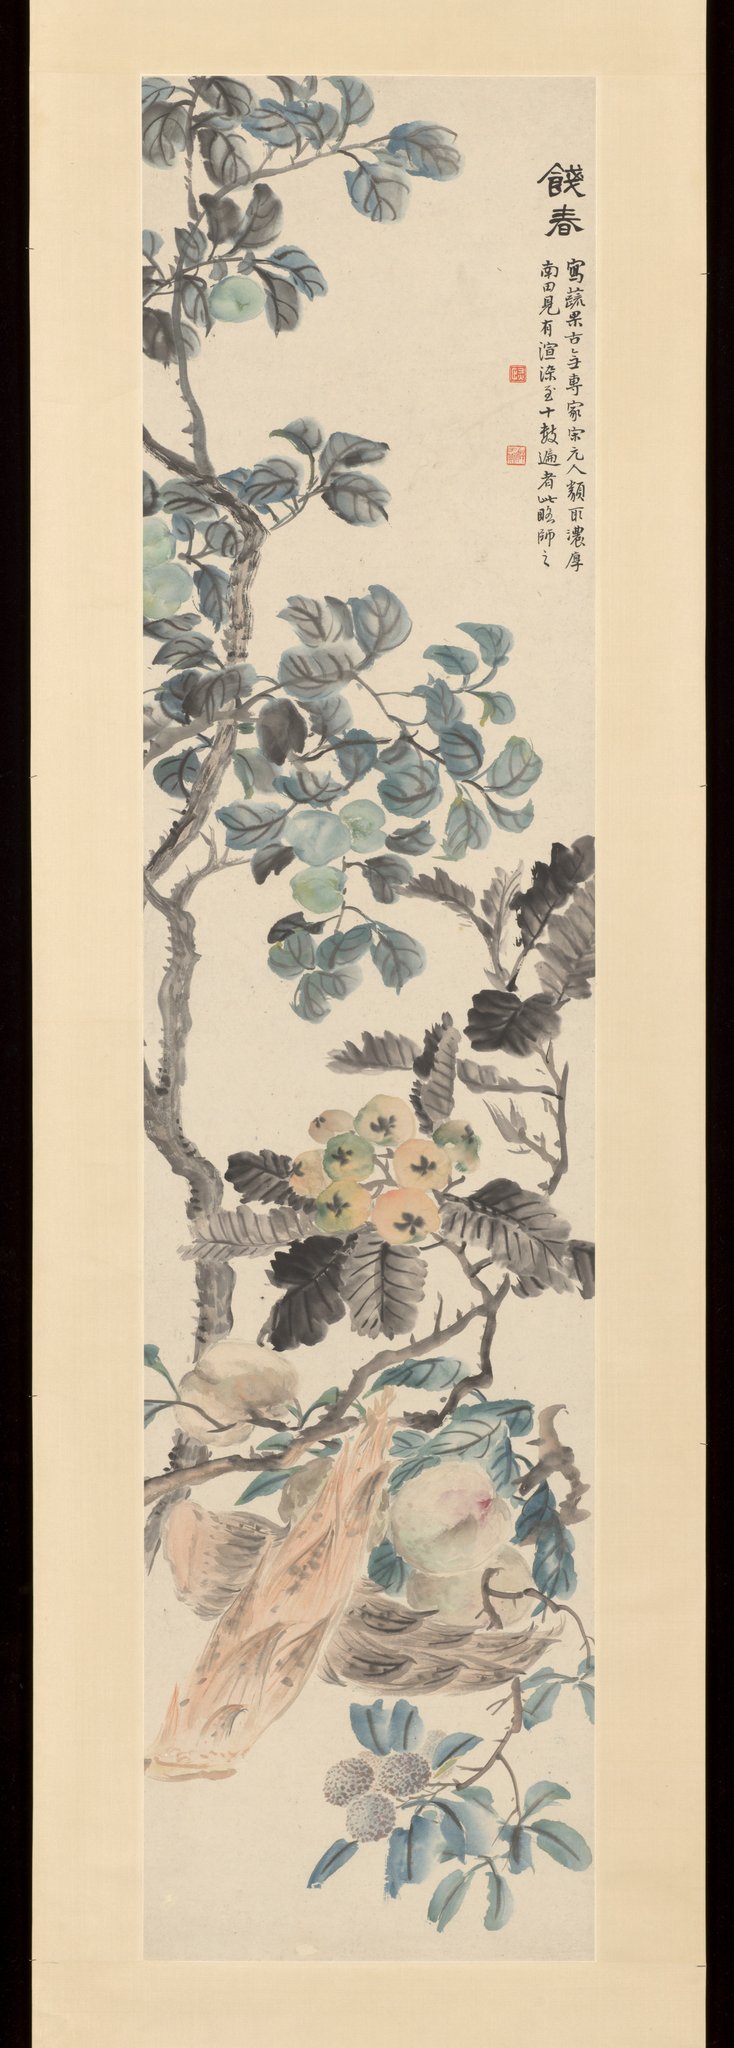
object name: hanging scroll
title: Flowers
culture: chinese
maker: lu hui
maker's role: artist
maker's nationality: chinese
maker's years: 1851-1920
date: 1851-1920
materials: ink, paper